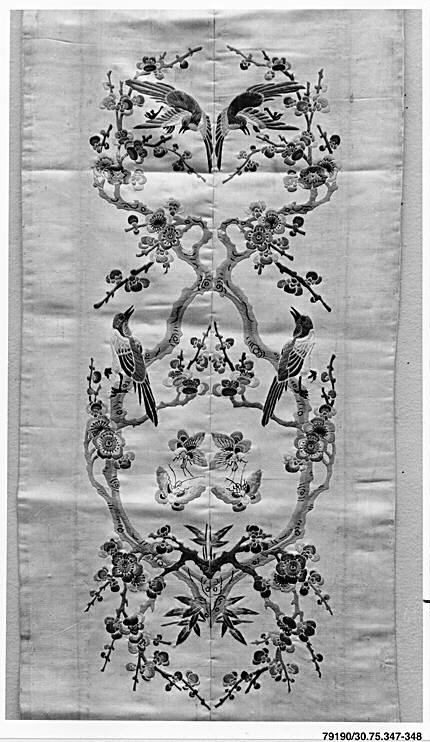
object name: sleeve band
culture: chinese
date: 1801-1900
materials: silk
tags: birds,flowers